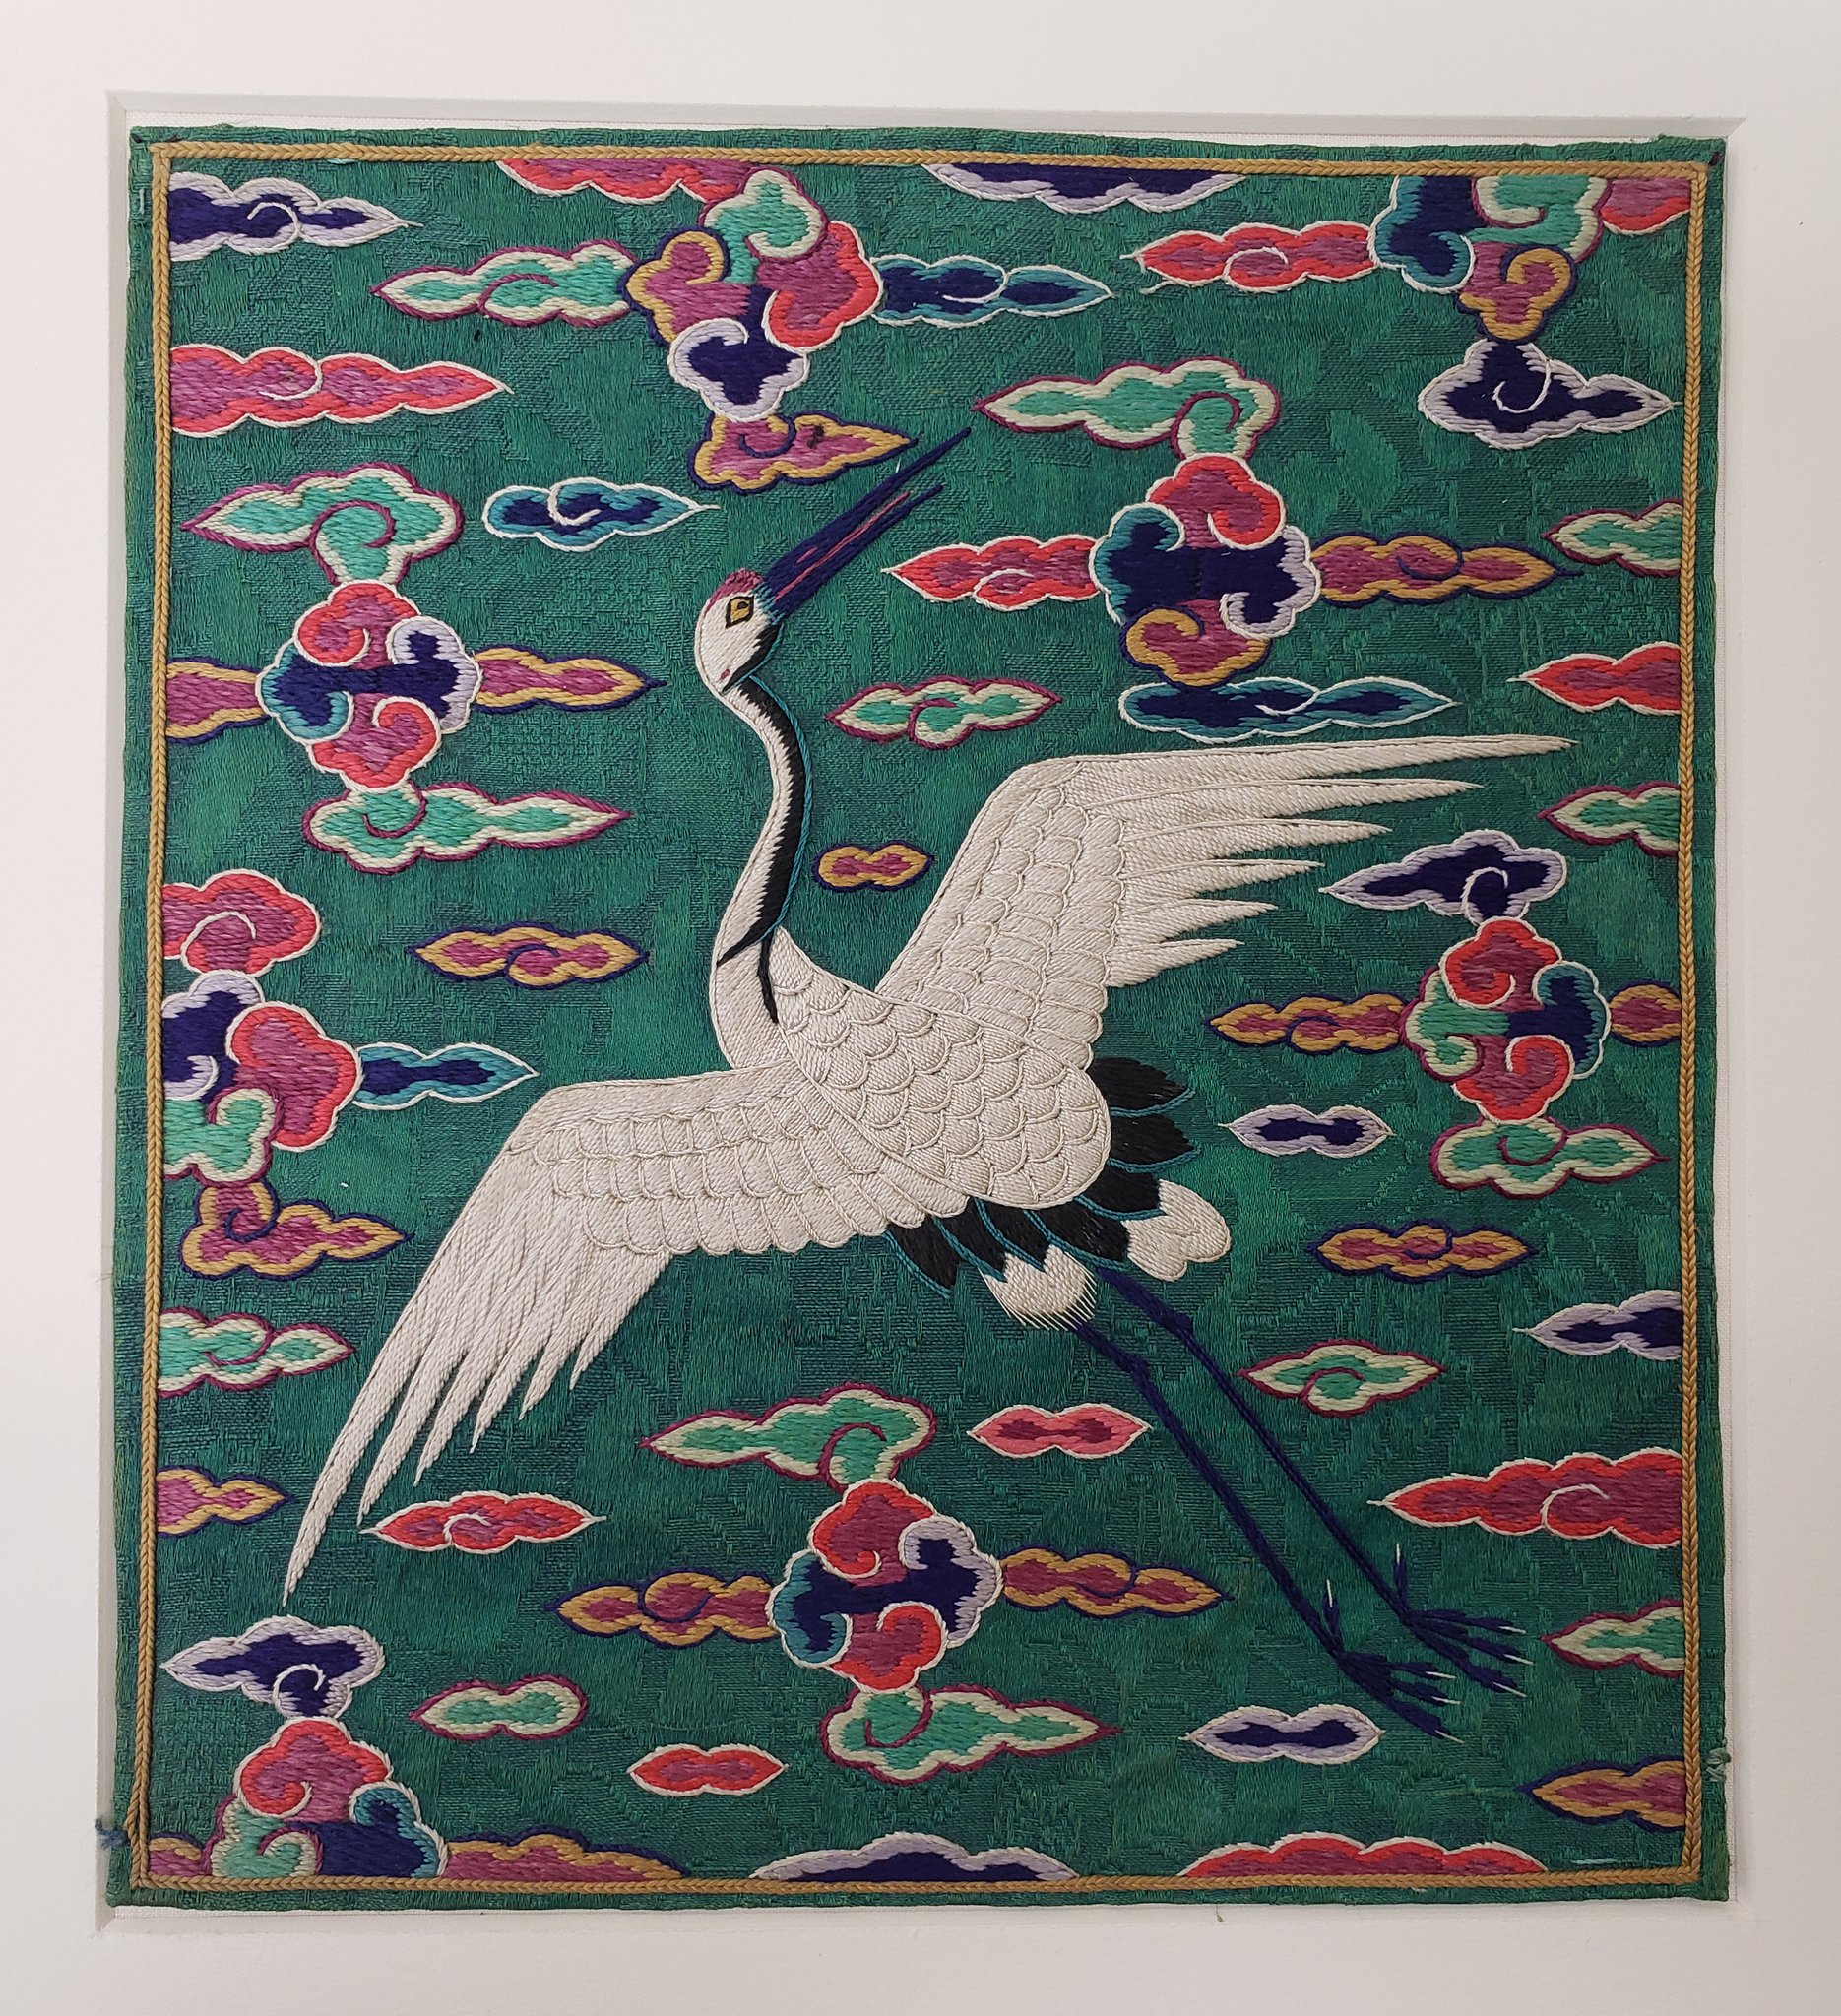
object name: rank badge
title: Civil-Official Hyungbae (Rank Badge)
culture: korean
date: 1867-1900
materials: silk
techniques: damask, embroidery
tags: cranes